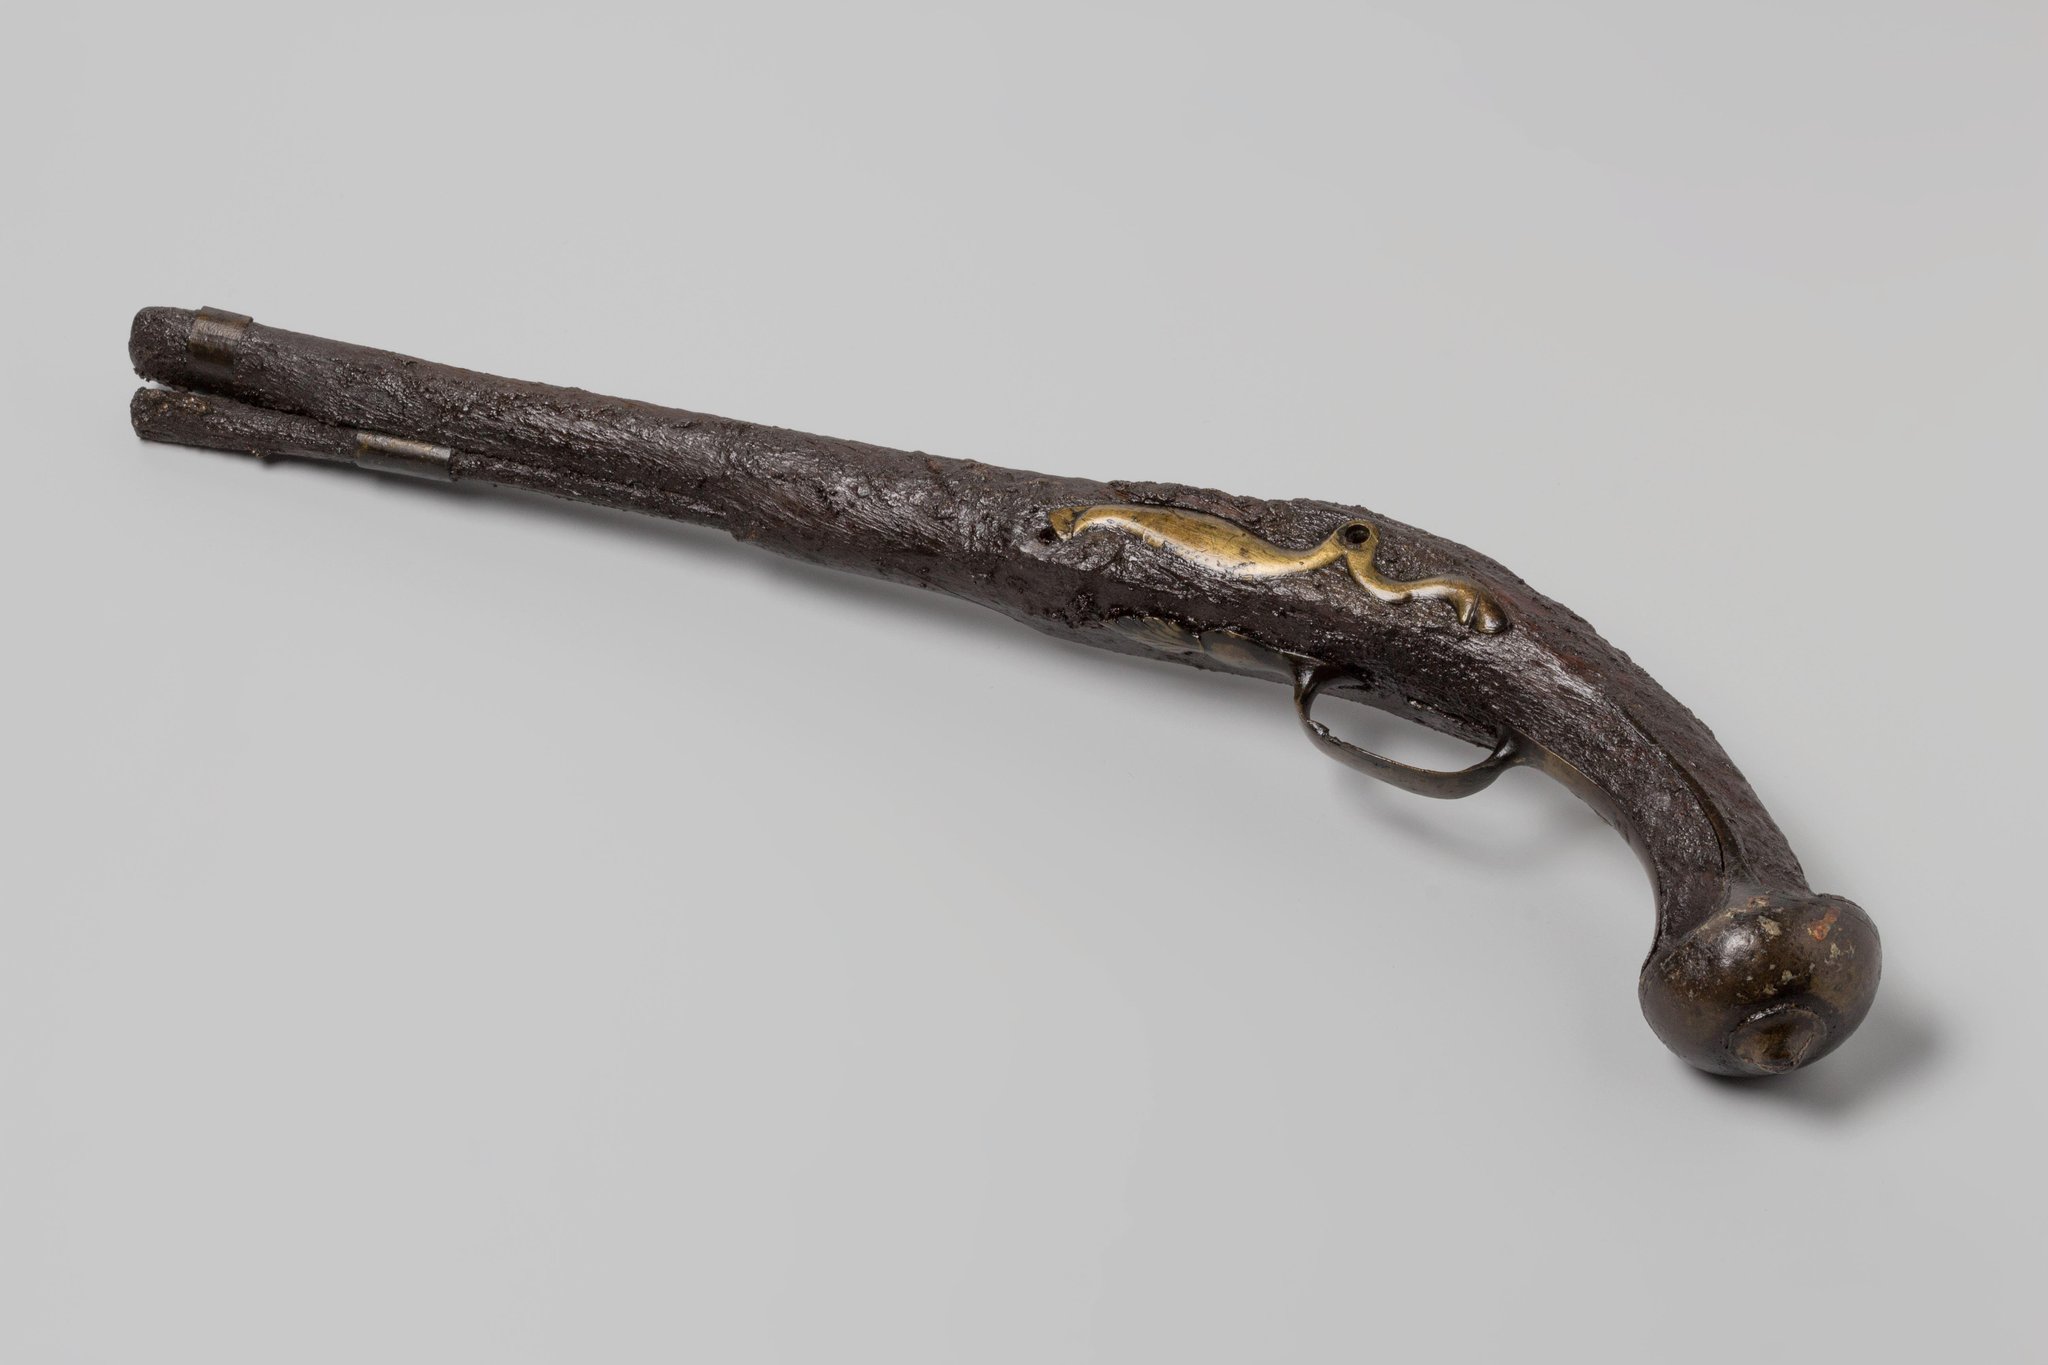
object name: pistol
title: Pistol with side plate from the wreck of the Dutch East Indiaman Hollandia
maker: Anonymous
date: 1700-1743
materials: copper, wood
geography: netherlands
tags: verenigde oostindische compagnie, hollandia (schip), annet